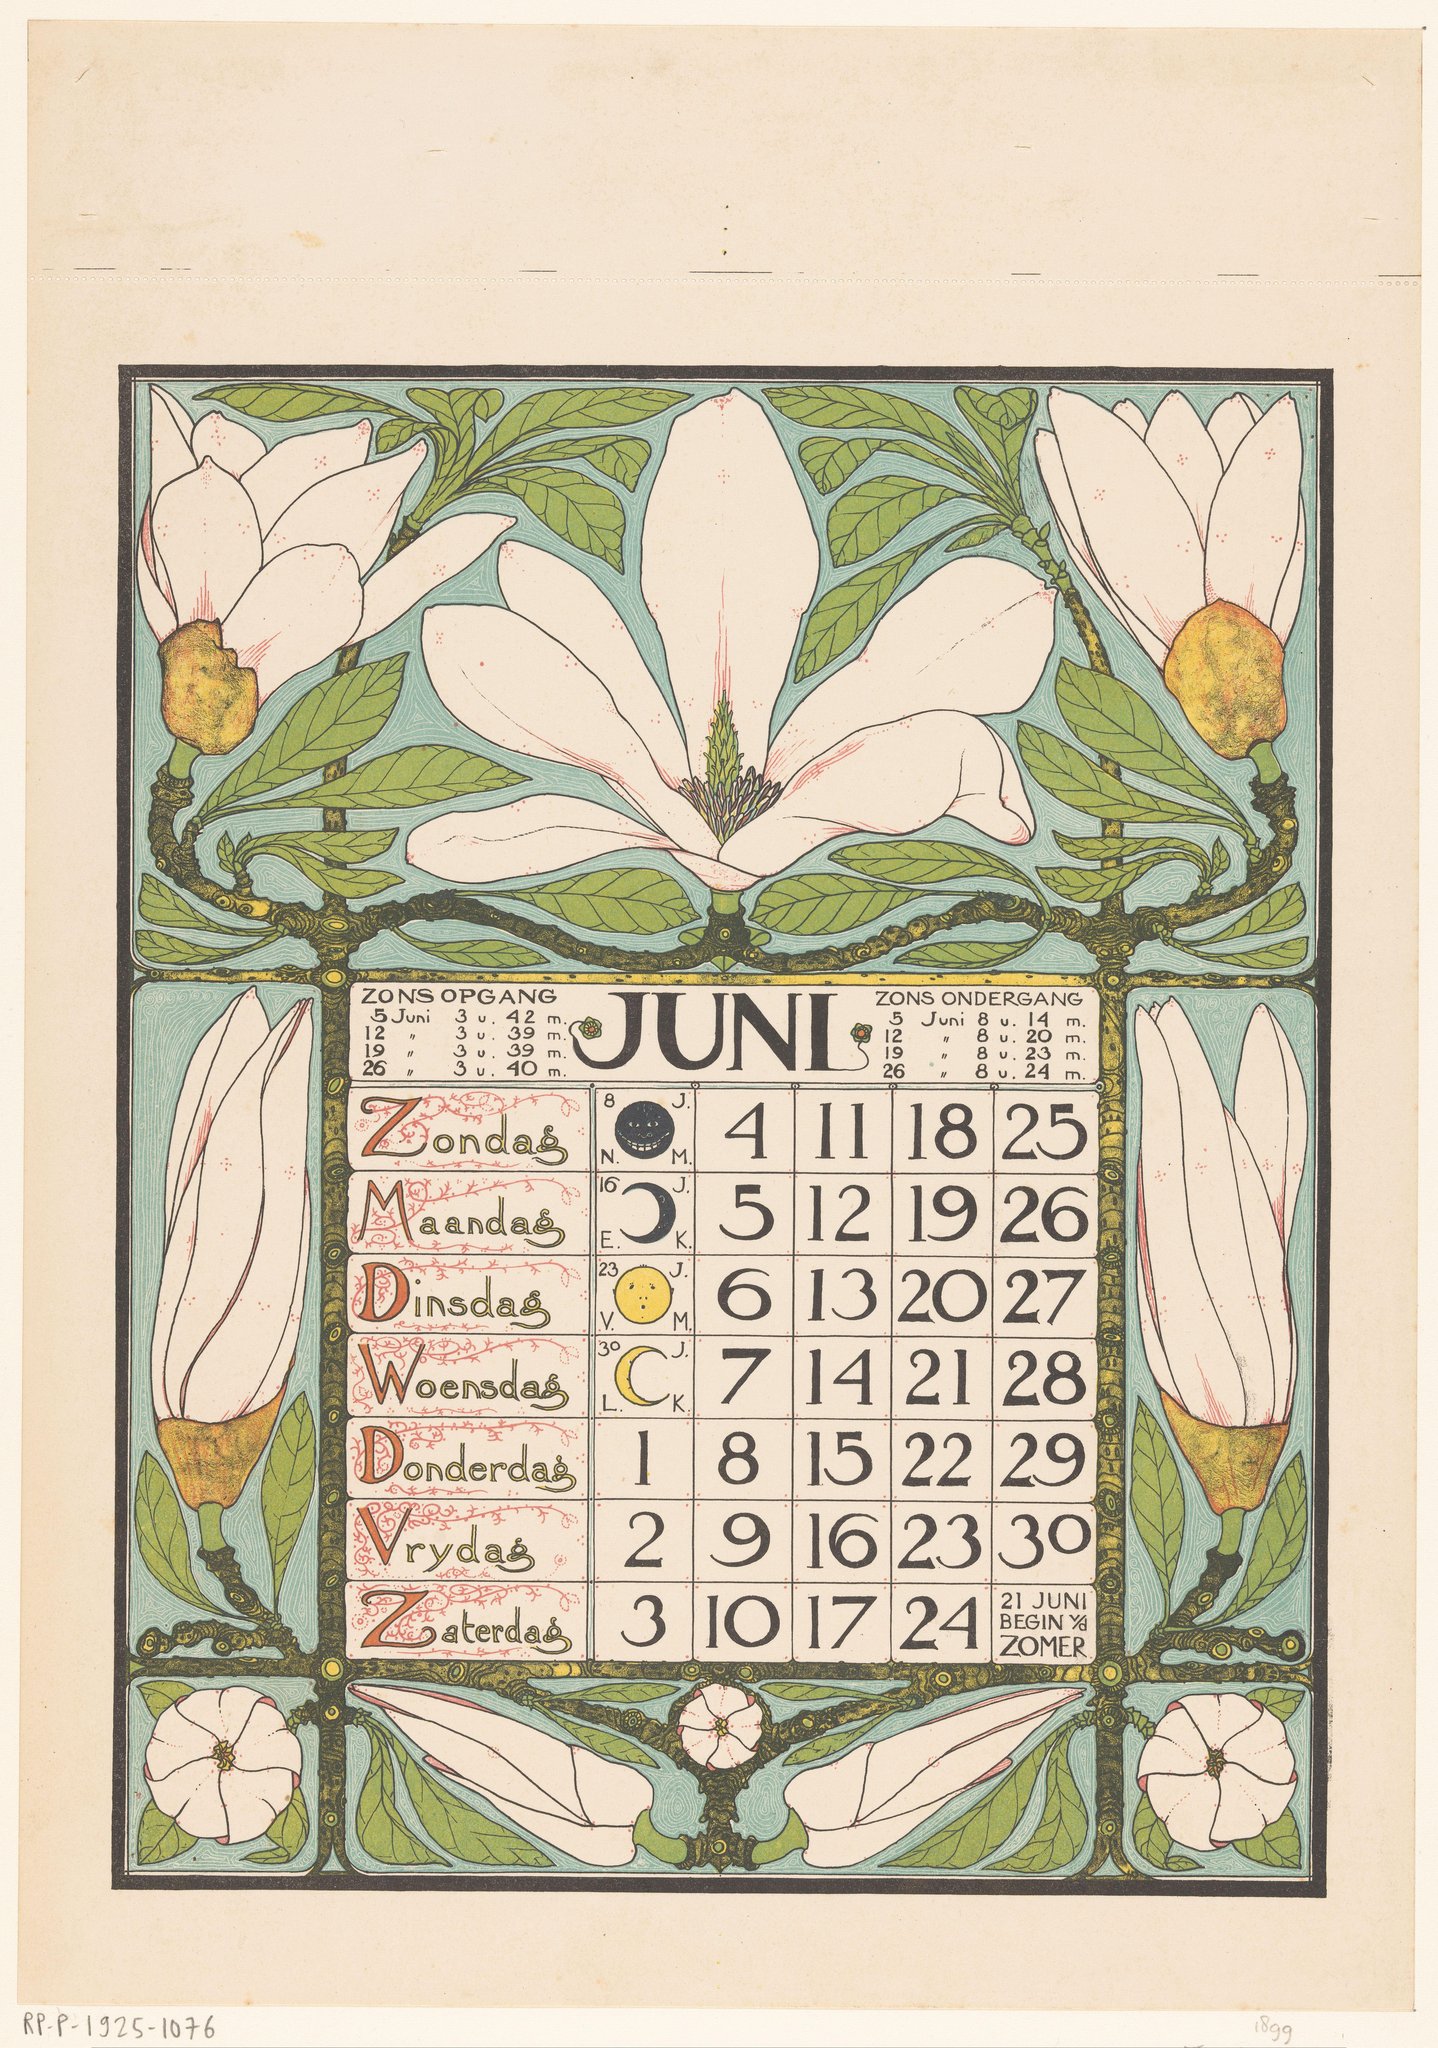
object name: print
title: Kalenderblad voor juni 1899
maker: theo nieuwenhuis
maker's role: designer, draughtsman, print maker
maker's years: 1866-1951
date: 1898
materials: paper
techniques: lithograph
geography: amsterdam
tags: flowers, ornament derived from plant forms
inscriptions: collector's mark: Lugt 2228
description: In 1898 vervaardigden Gerrit Willem Dijsselhof, Carel Adolph Lion Cachet en Theo Nieuwenhuis samen een kalender voor het jaar 1899. Nieuwenhuis nam het ontwerp van de maanden maart, juni, september en december op zich.